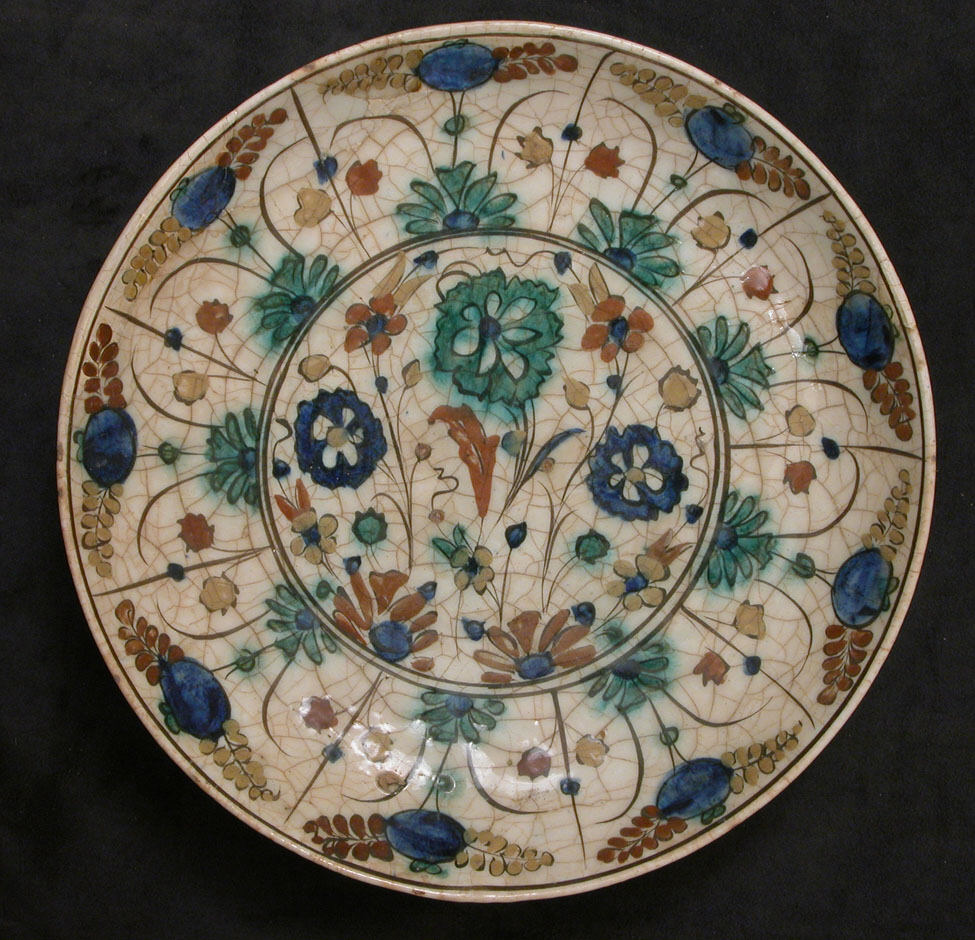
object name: dish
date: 1601-1700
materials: stonepaste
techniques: painting, underglaze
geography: iran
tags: flowers